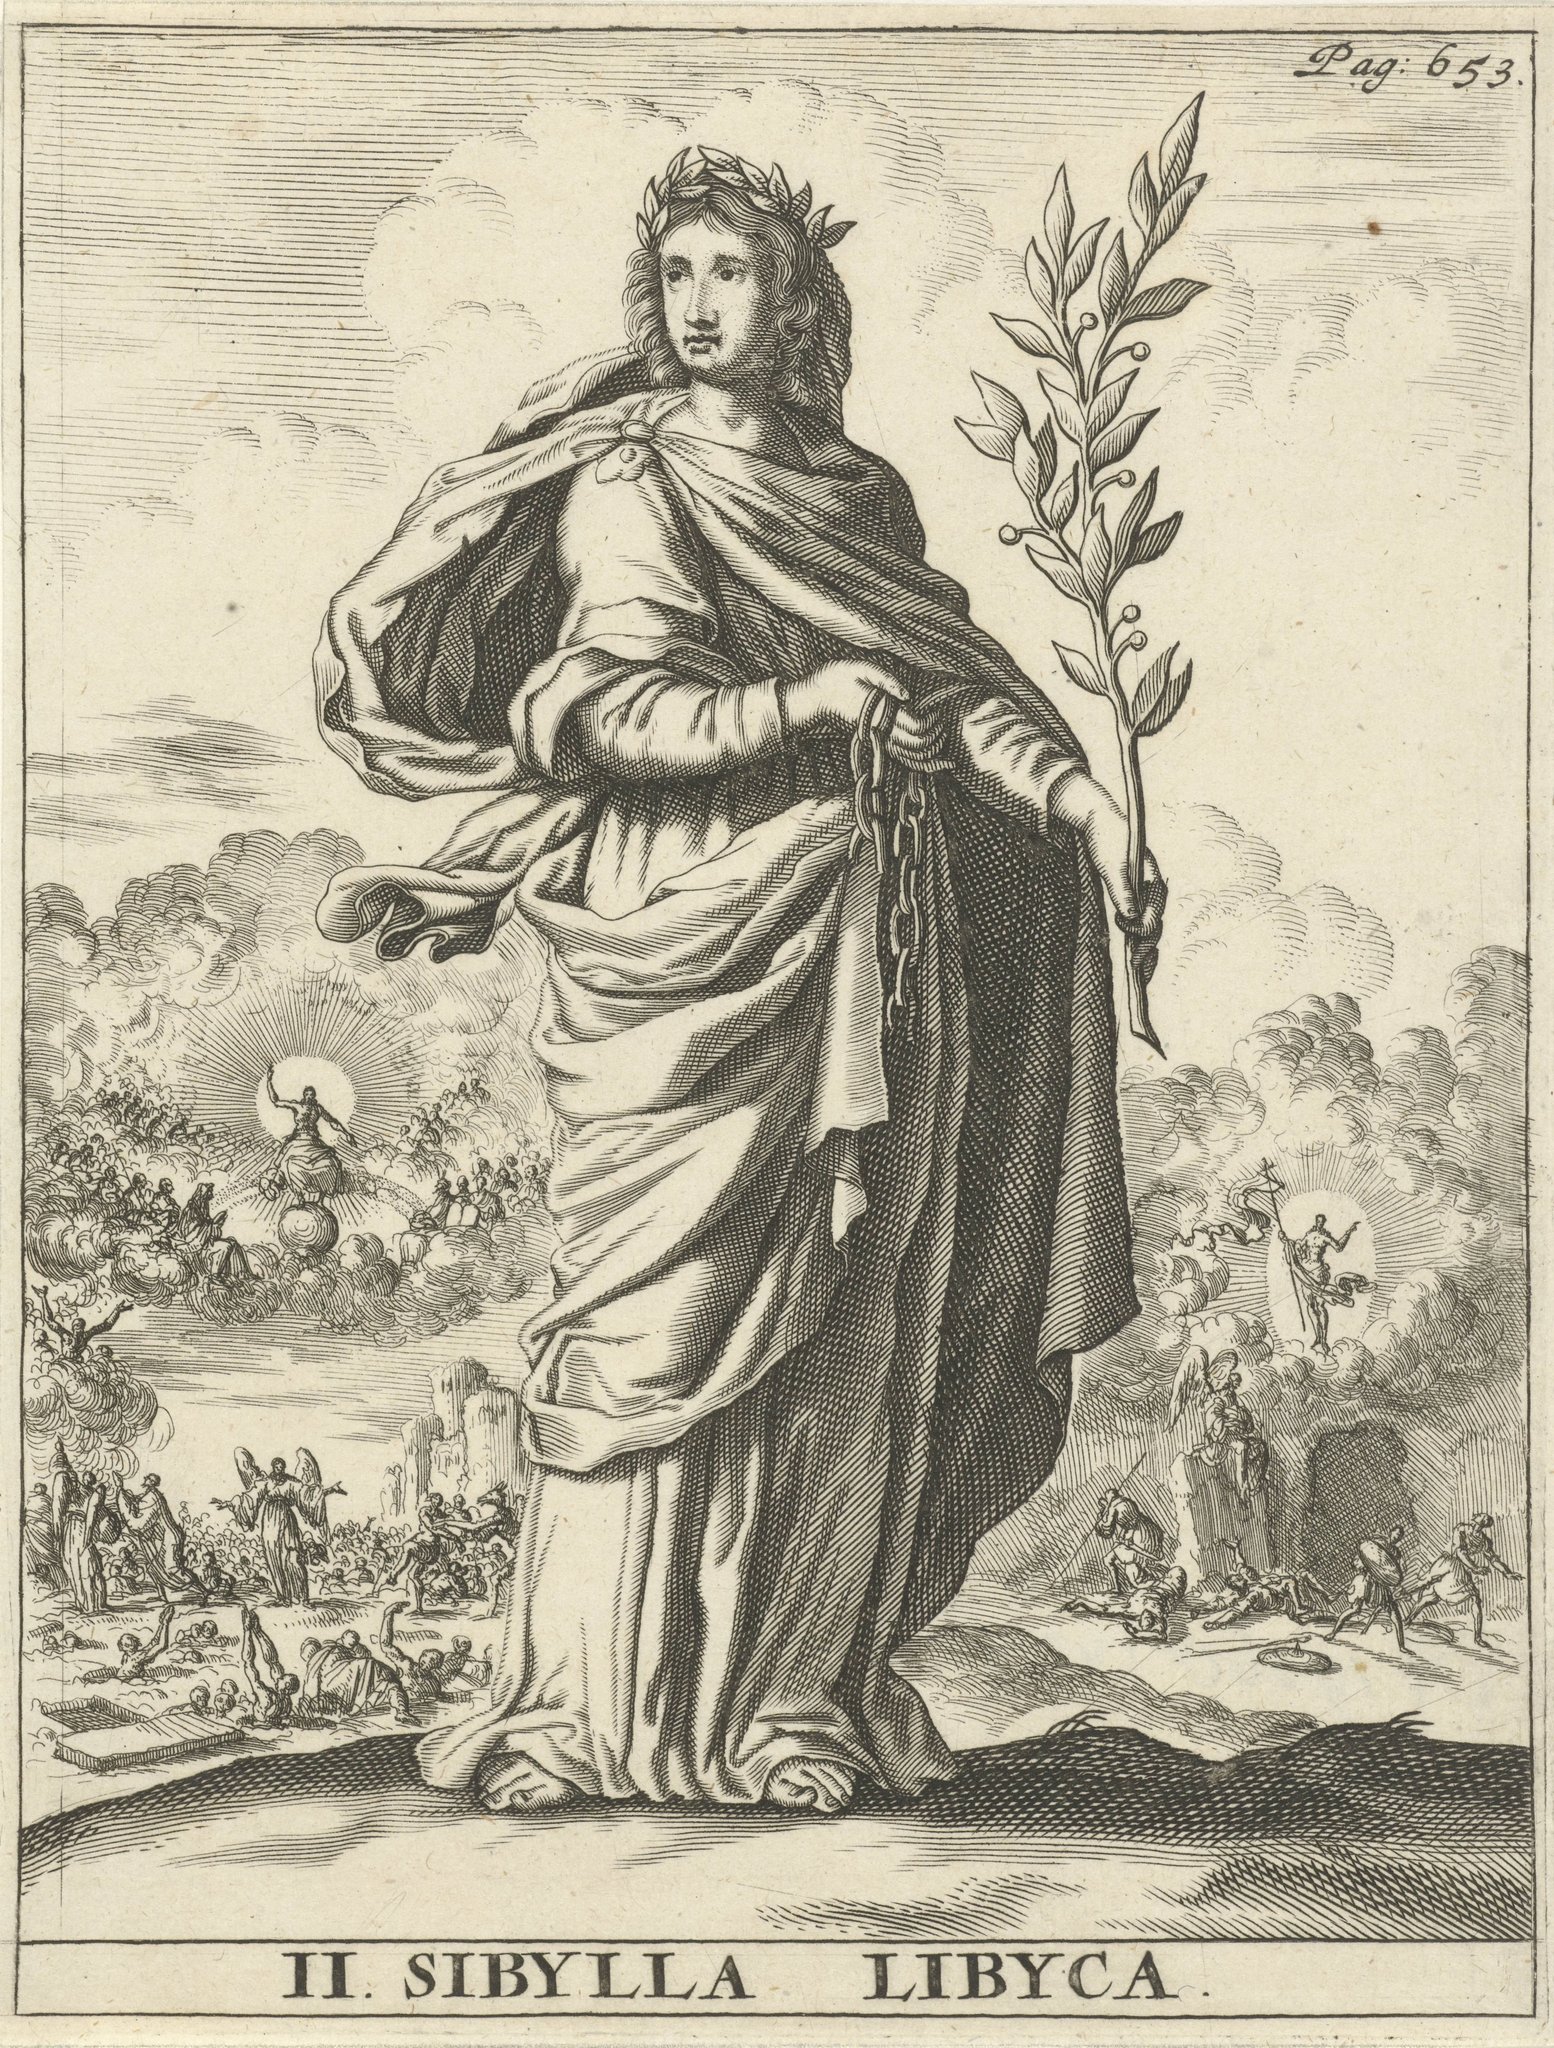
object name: print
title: Libische Sibille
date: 1684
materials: paper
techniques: engraving, etching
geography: amsterdam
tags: last judgement, christ, usually holding a banner, arises from the grave; often combined with sleeping and/or frightened soldiers, sibyls (with name)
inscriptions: collector's mark: Lugt 2228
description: Libische Sibille. Op de achtergrond de verbeelding van het Laatste Oordeel en de Opstanding. Prent rechtsboven gemerkt: Pag: 653.